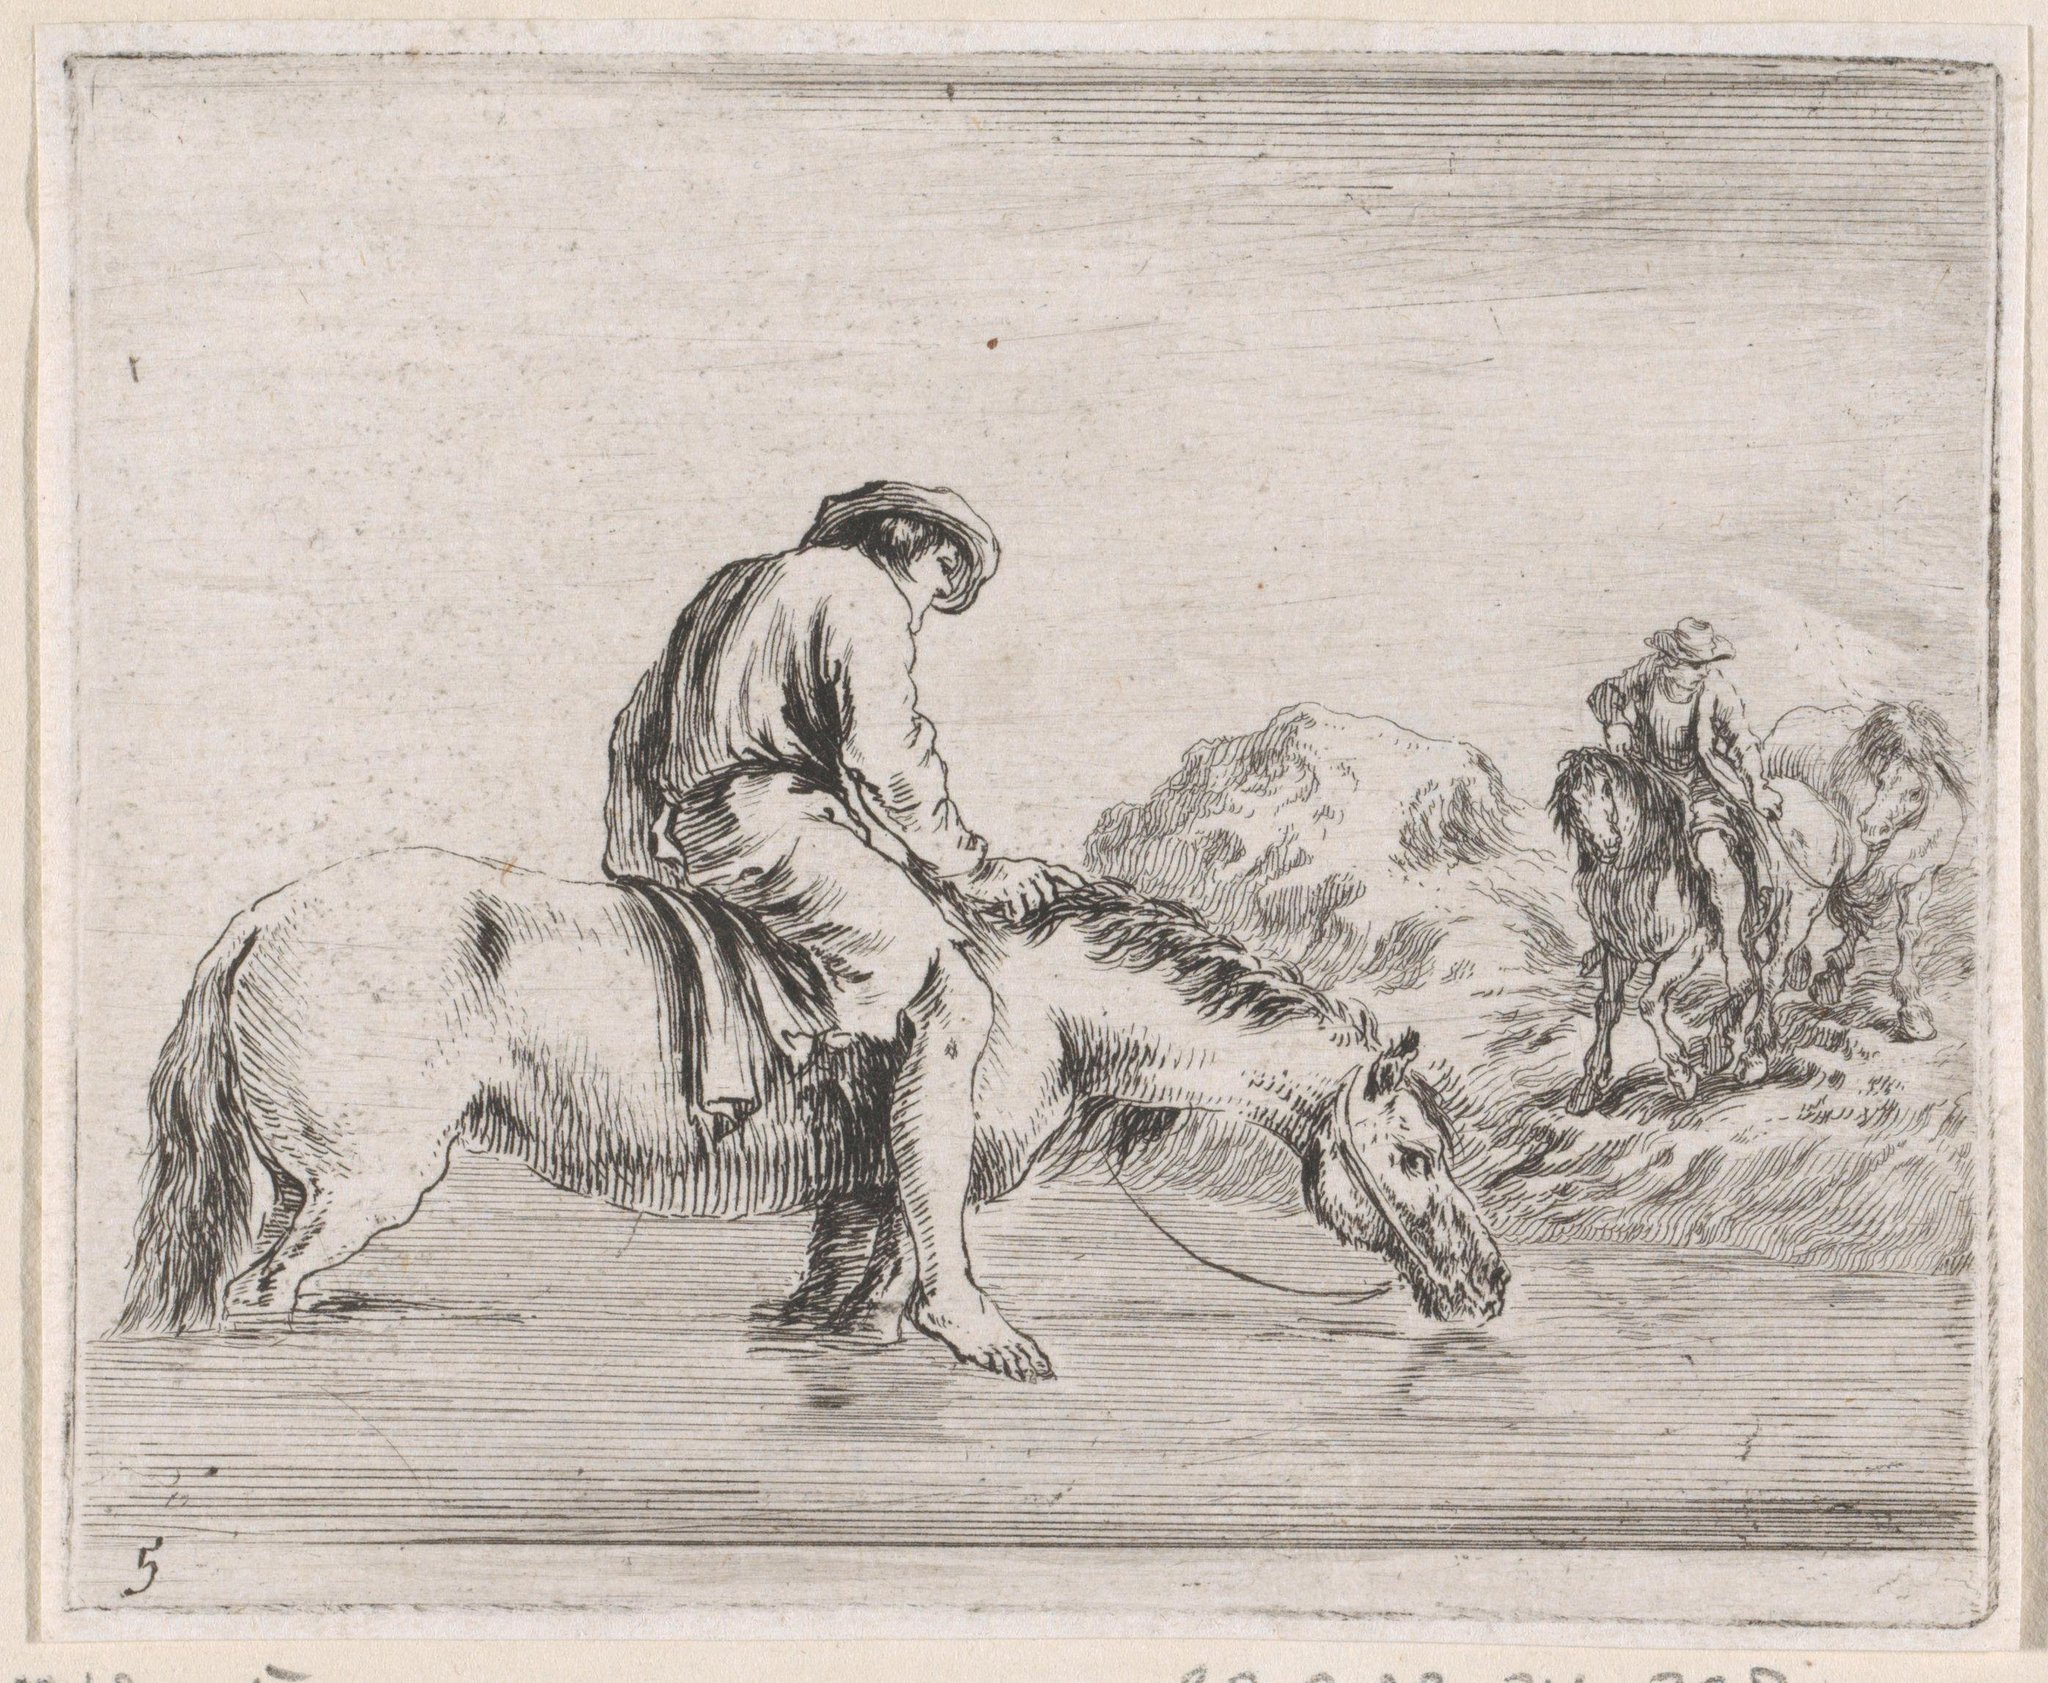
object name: print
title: Paard met berijder in water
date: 1632-1664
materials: paper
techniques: etching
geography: paris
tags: riding a horse, ass, or mule; rider, horseman, horse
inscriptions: collector's mark: Lugt 240